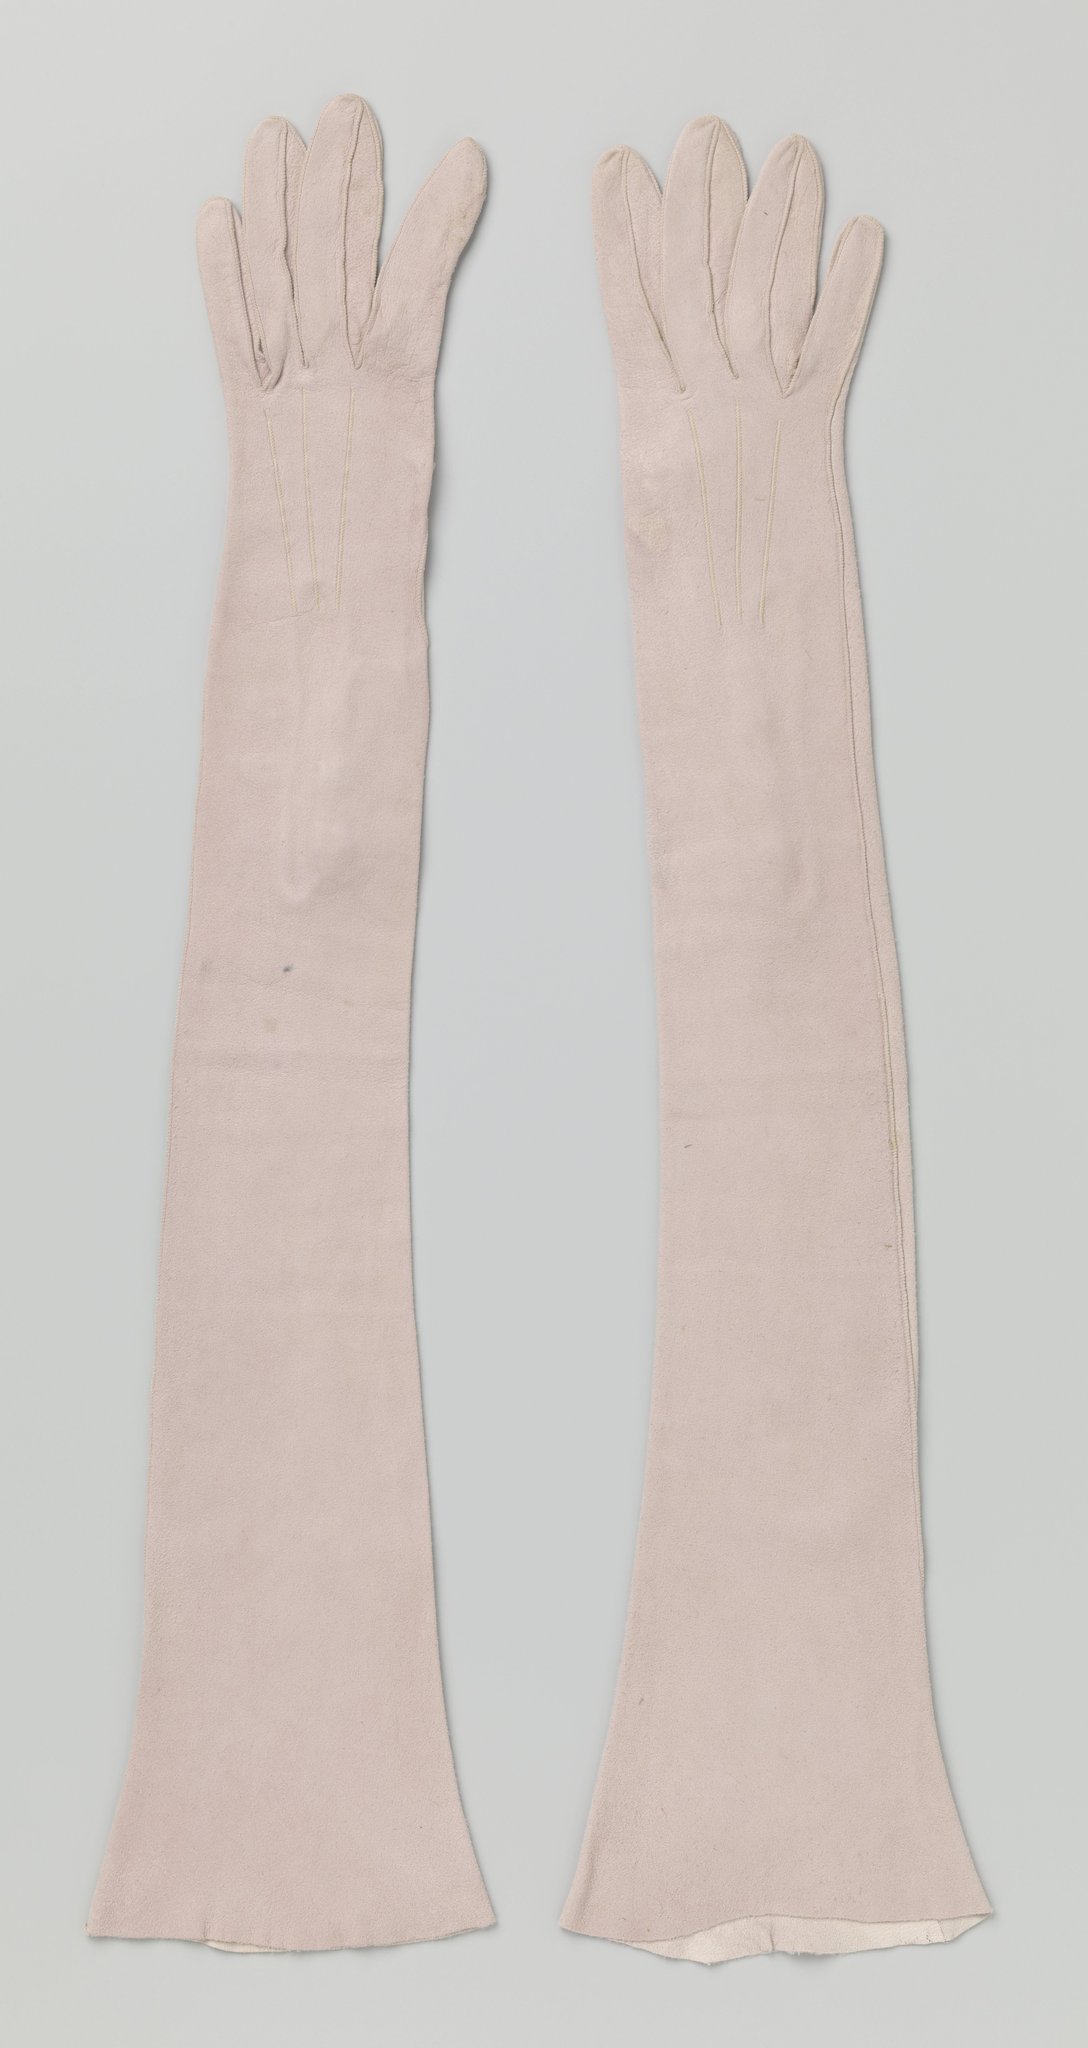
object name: glove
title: Pair of evening gloves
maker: Anonymous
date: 1900-1915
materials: leather, metal, plastic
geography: netherlands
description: Evening gloves were generally longer than those for everyday use. They were worn on special occasions, with evening dresses and coats. Gloves for formal events varied in length: from just over the wrist, to well over the elbow.